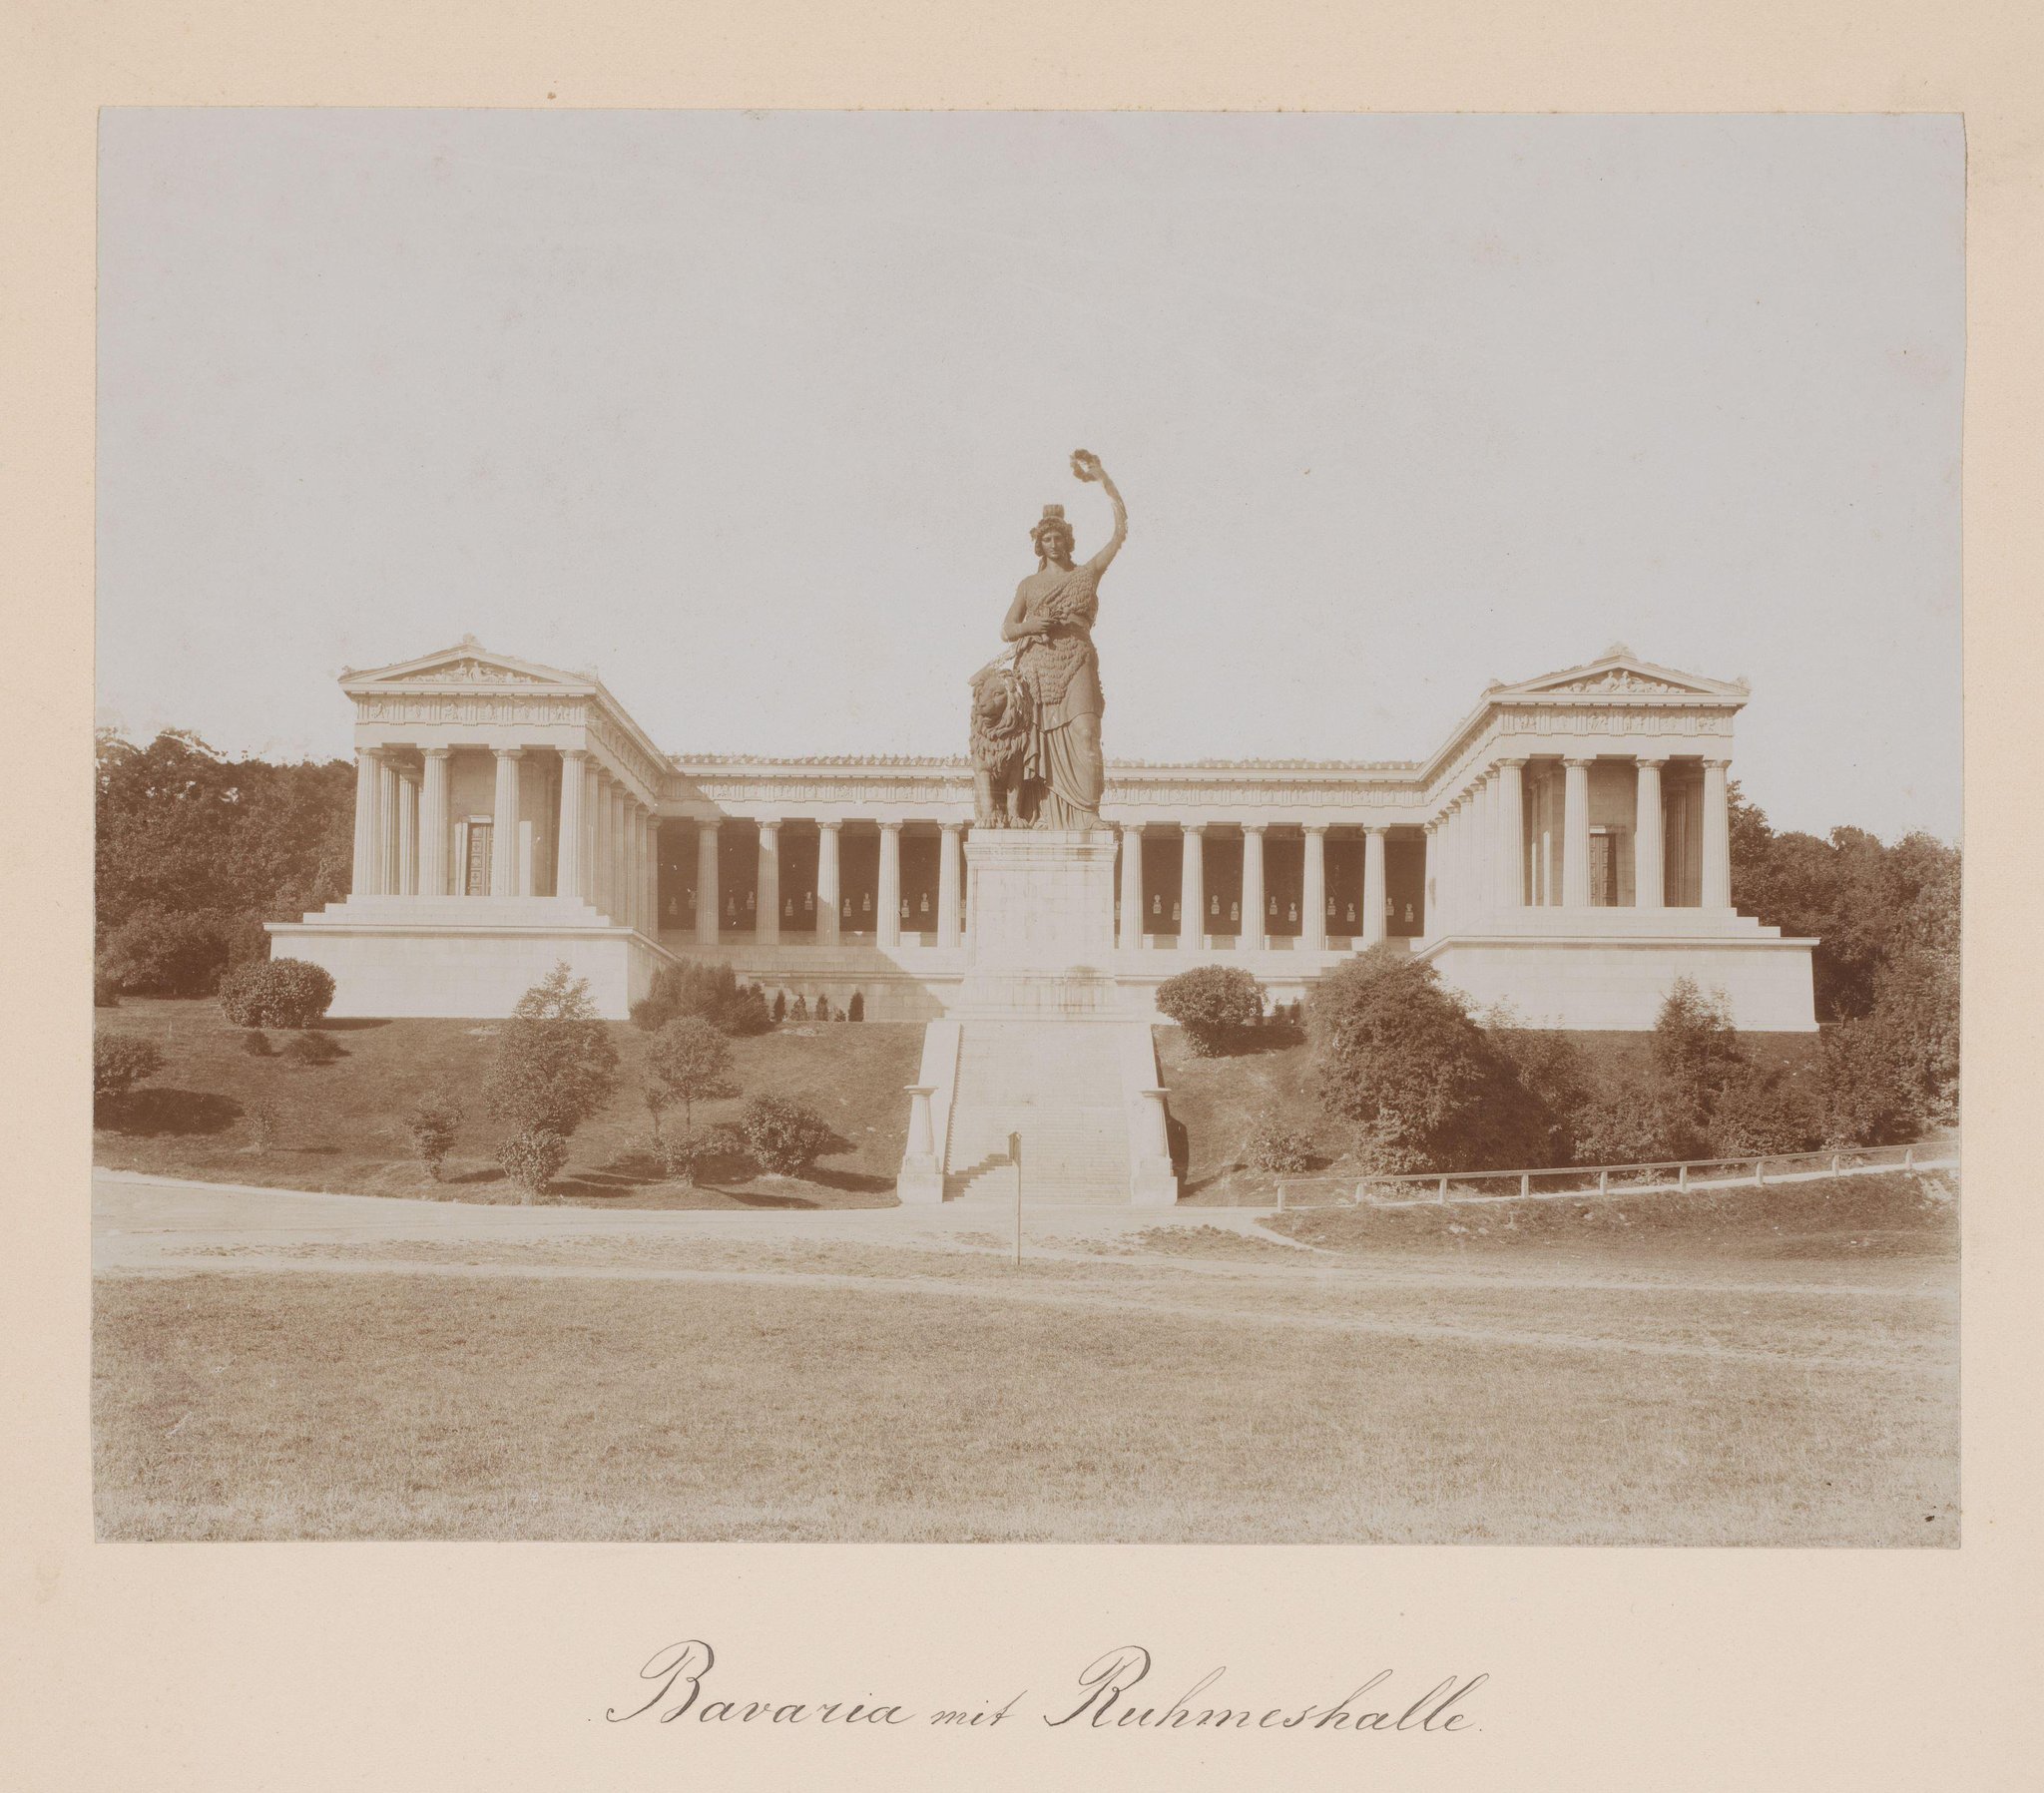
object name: photograph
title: Bavaria met Ruhmeshalle, München, Duitsland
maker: Anonymous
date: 1880-1910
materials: cardboard, photographic support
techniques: collodion silver print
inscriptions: inscription: ‘Bavaria mit Ruhmeshalle.’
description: Standbeeld van Bavaria, beschermheilige van Baieren, met op de achtergrond de Ruhmeshalle (gebouwd in 1853 in opdracht van koning Lodewijk I van Baieren). Zij vormen een ensemble op de Theresienwiese in München.